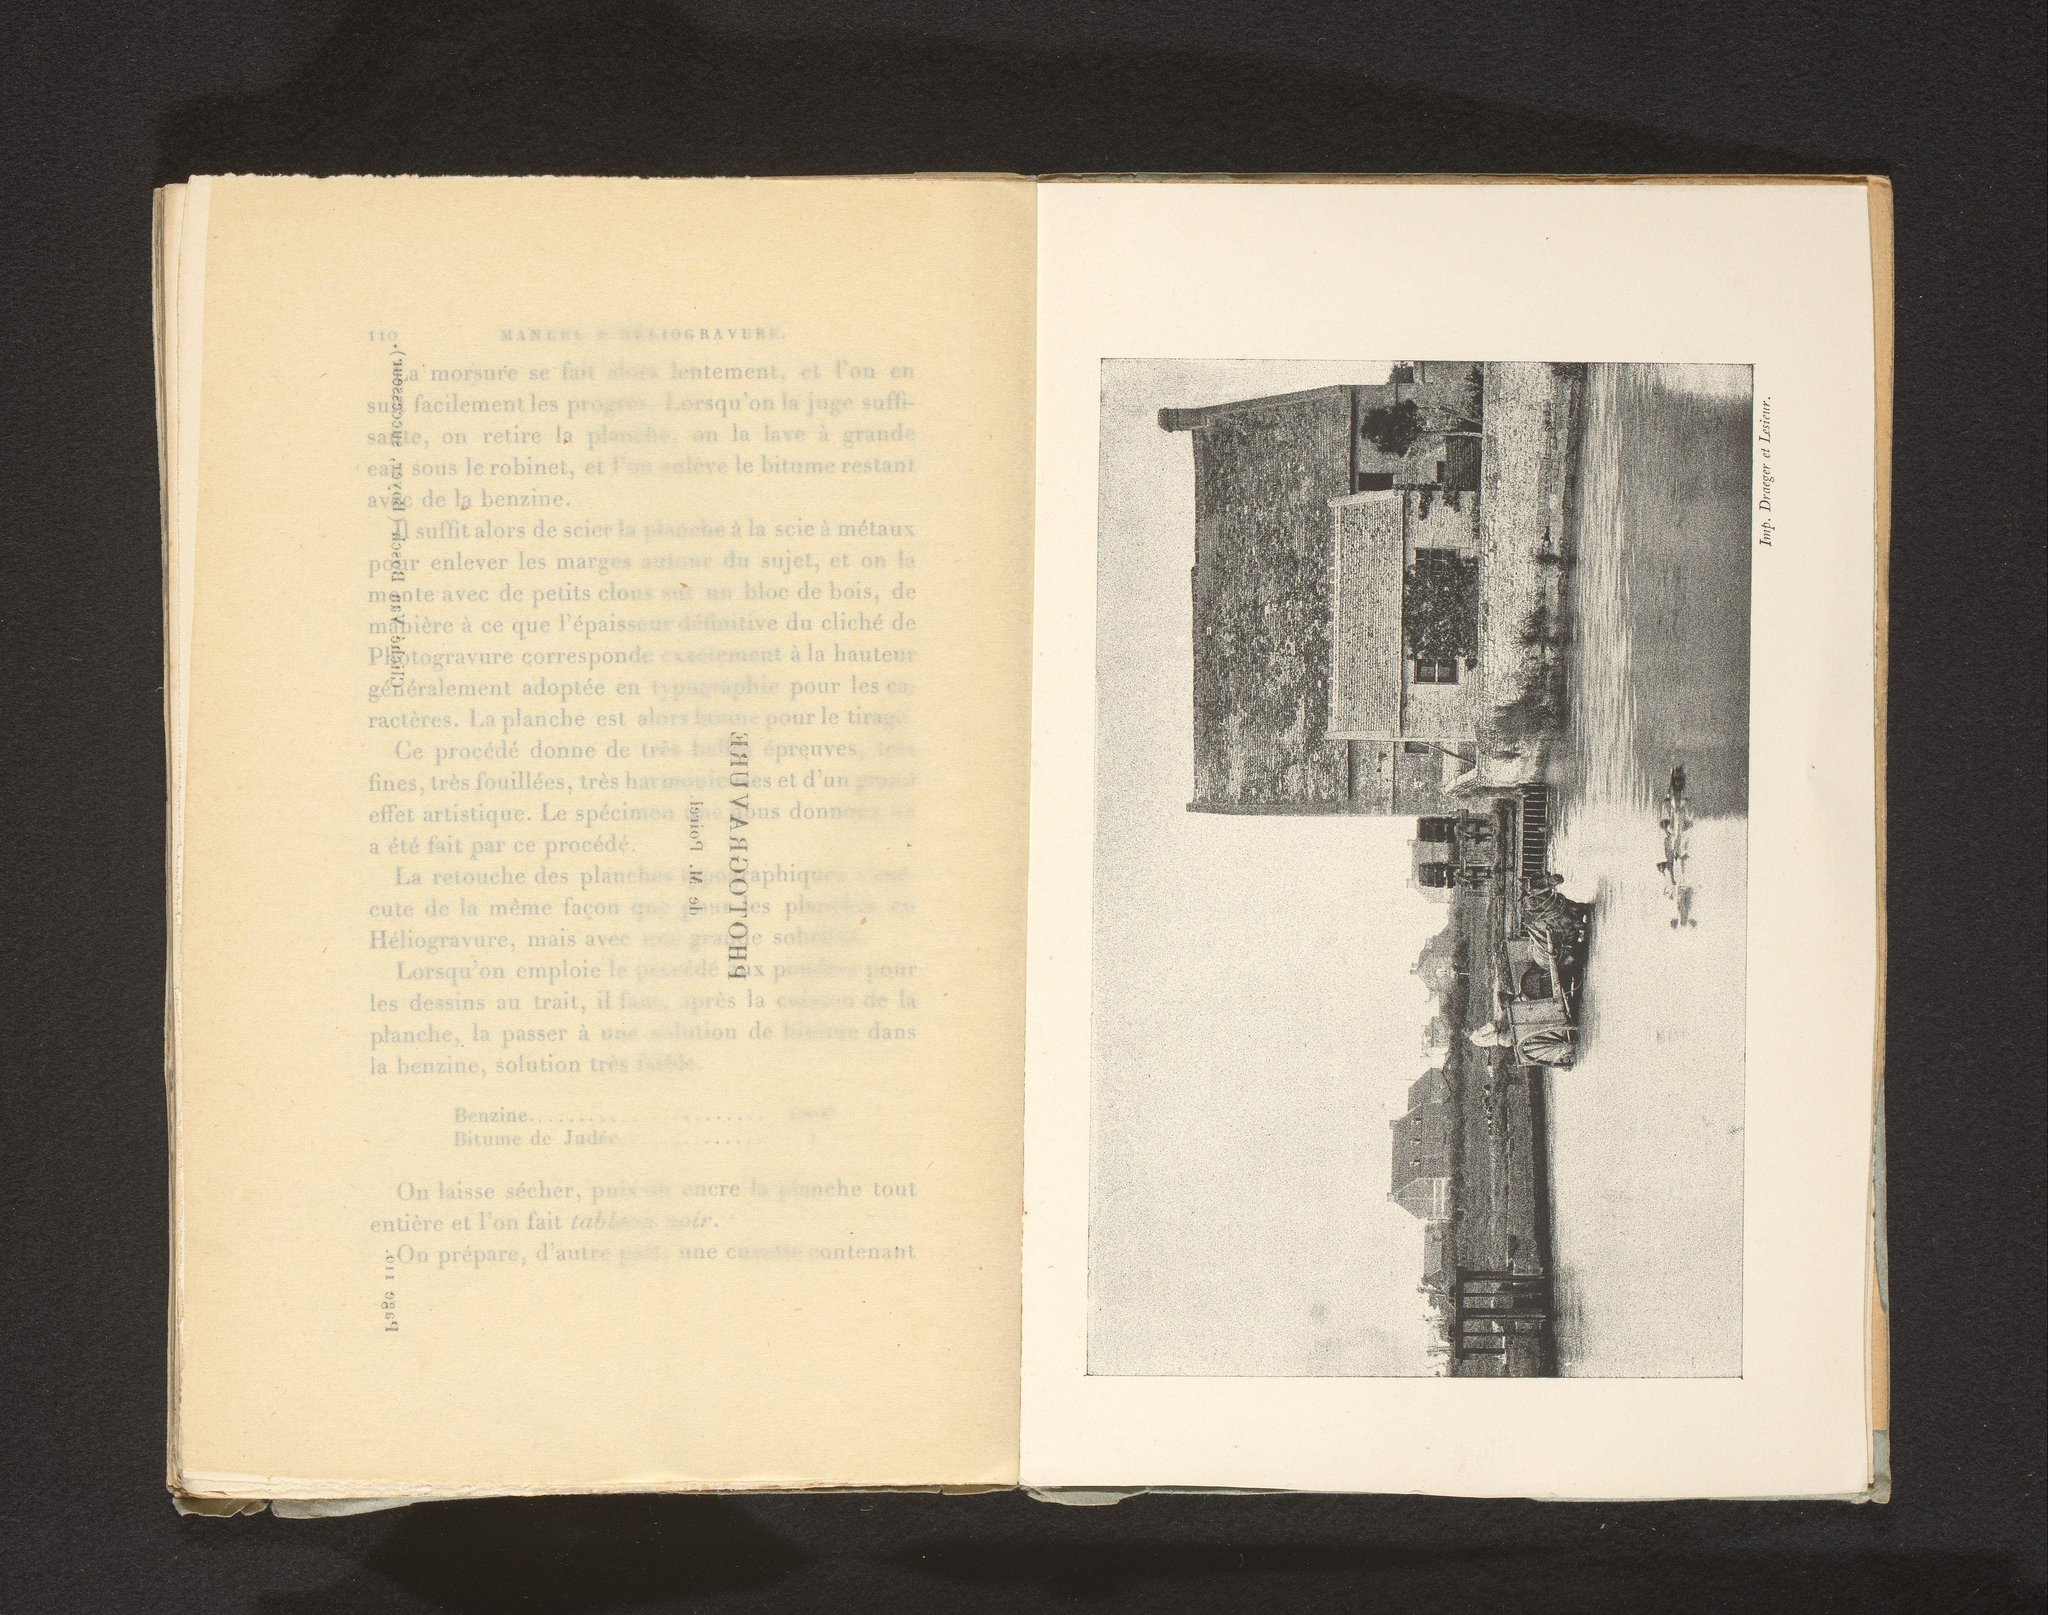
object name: page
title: Man in een paardenkar in het water voor een huis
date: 1880-1890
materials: paper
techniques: photolithography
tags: animal traction, animal-drawn vehicle (carriage etc.)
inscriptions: inscription: ‘Photogravure’